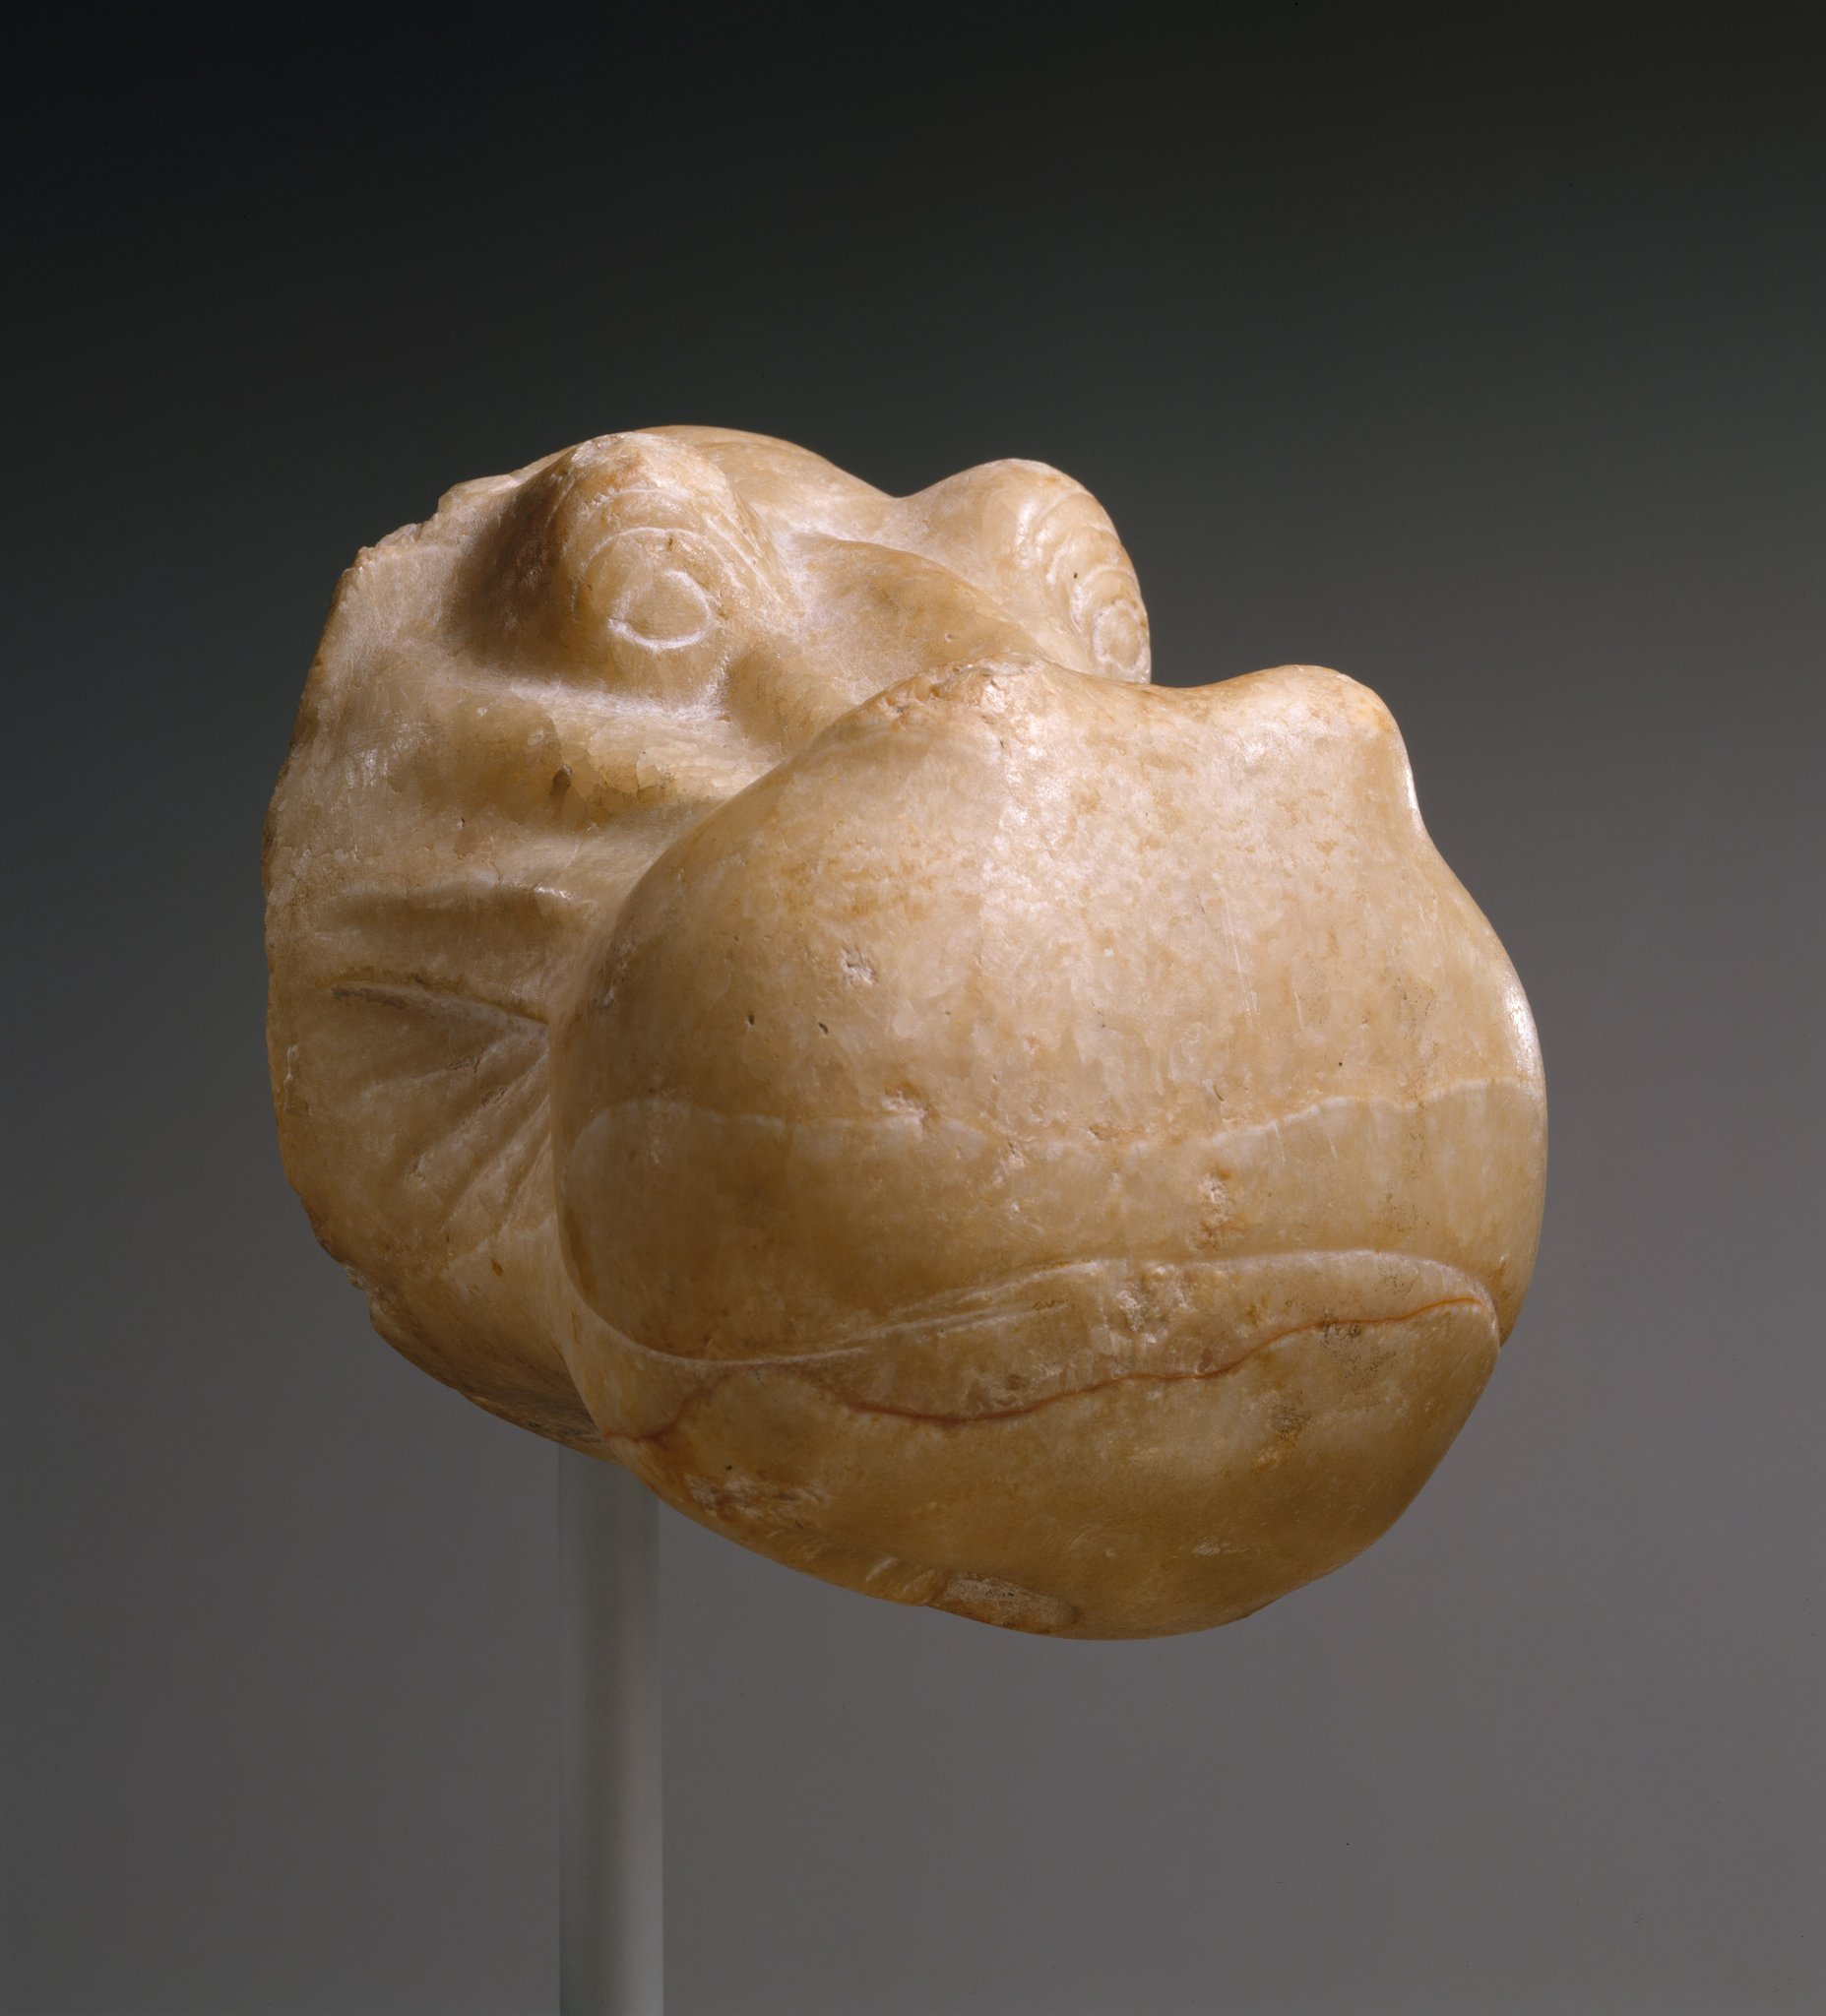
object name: head, hippopotamus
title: Head of a Hippopotamus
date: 1390-1352 BCE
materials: gesso, pigment, stone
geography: egypt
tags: hippos